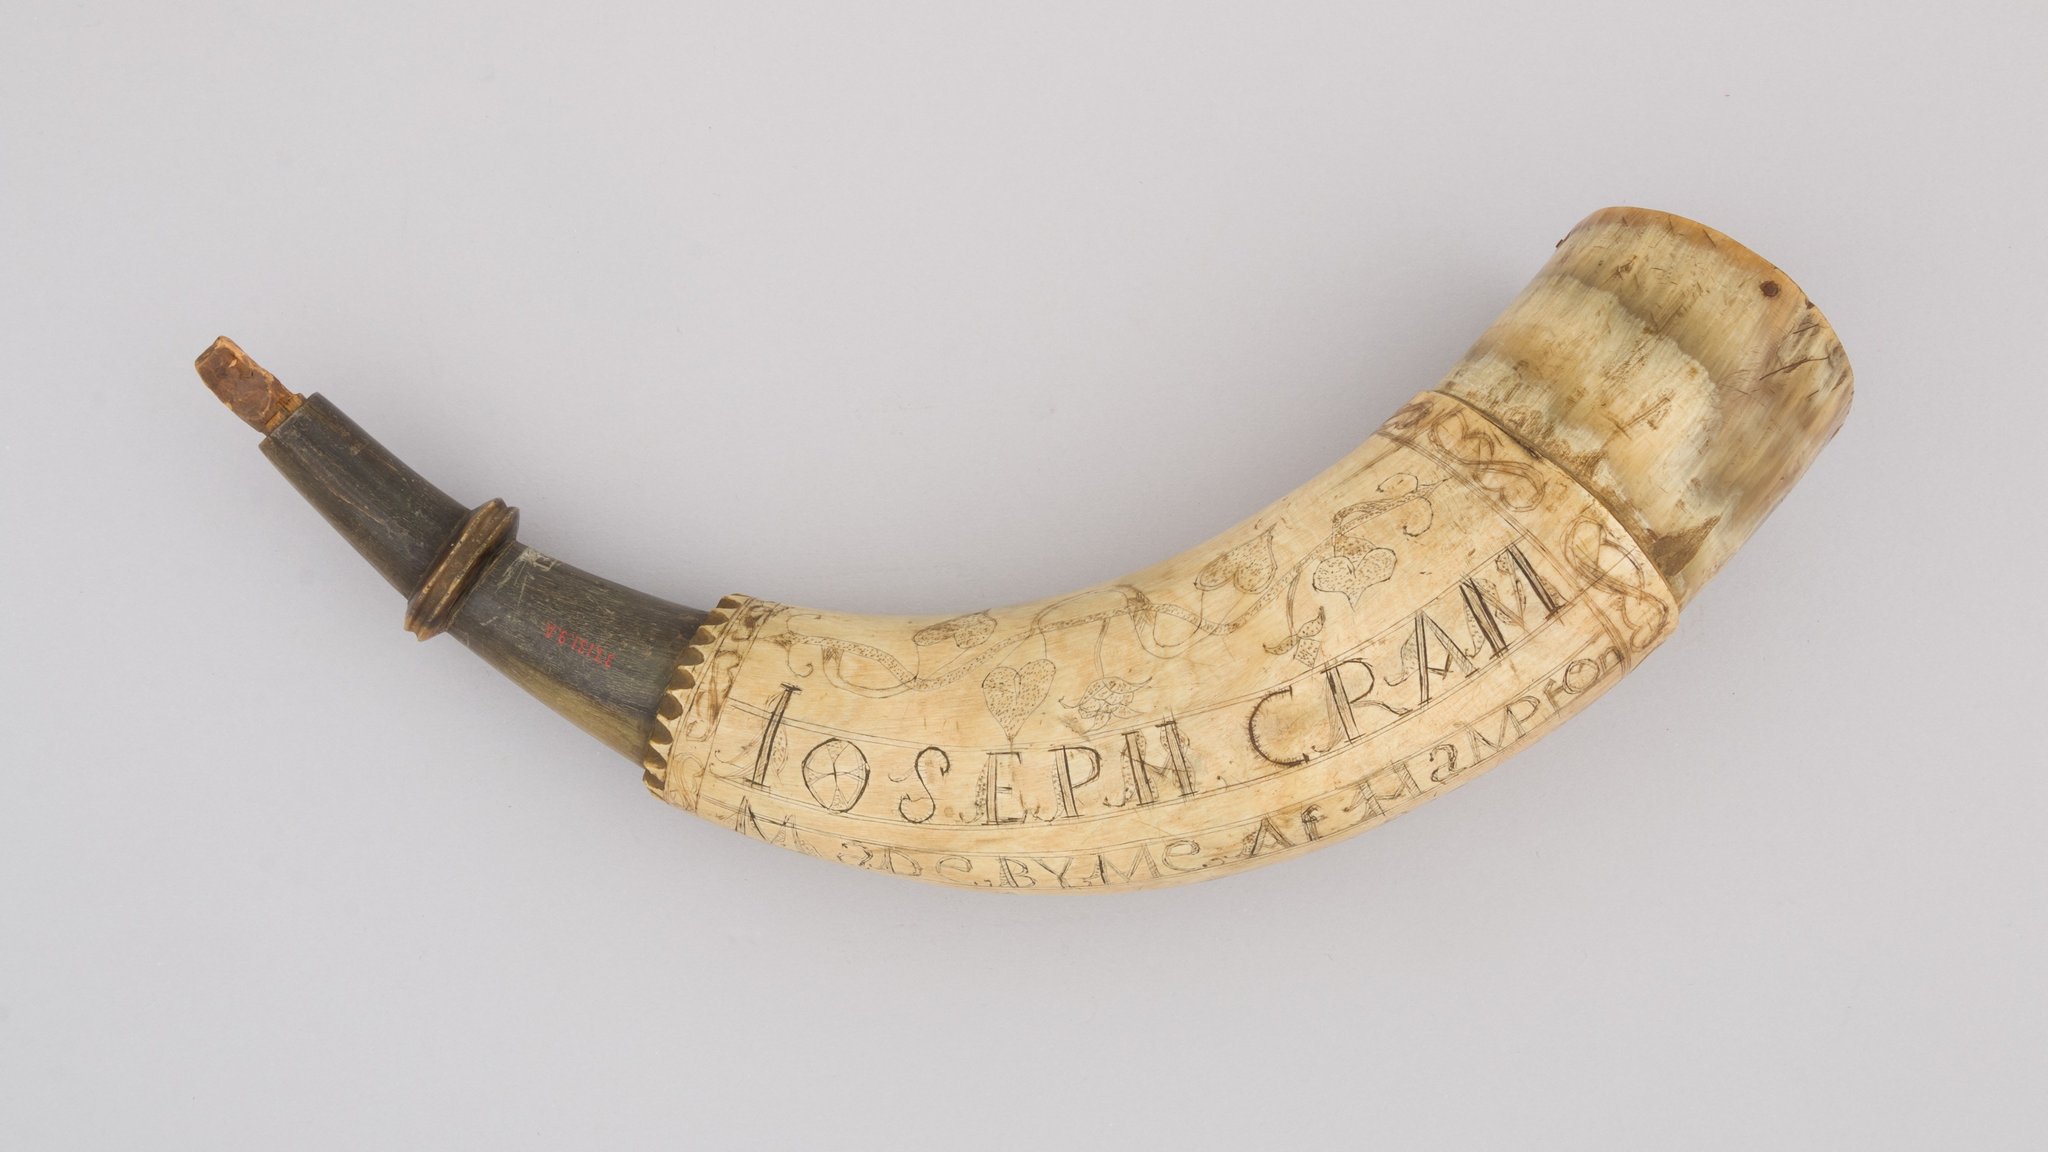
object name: powder horn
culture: colonial american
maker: joseph cram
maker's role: maker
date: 1764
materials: horn, wood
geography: united states